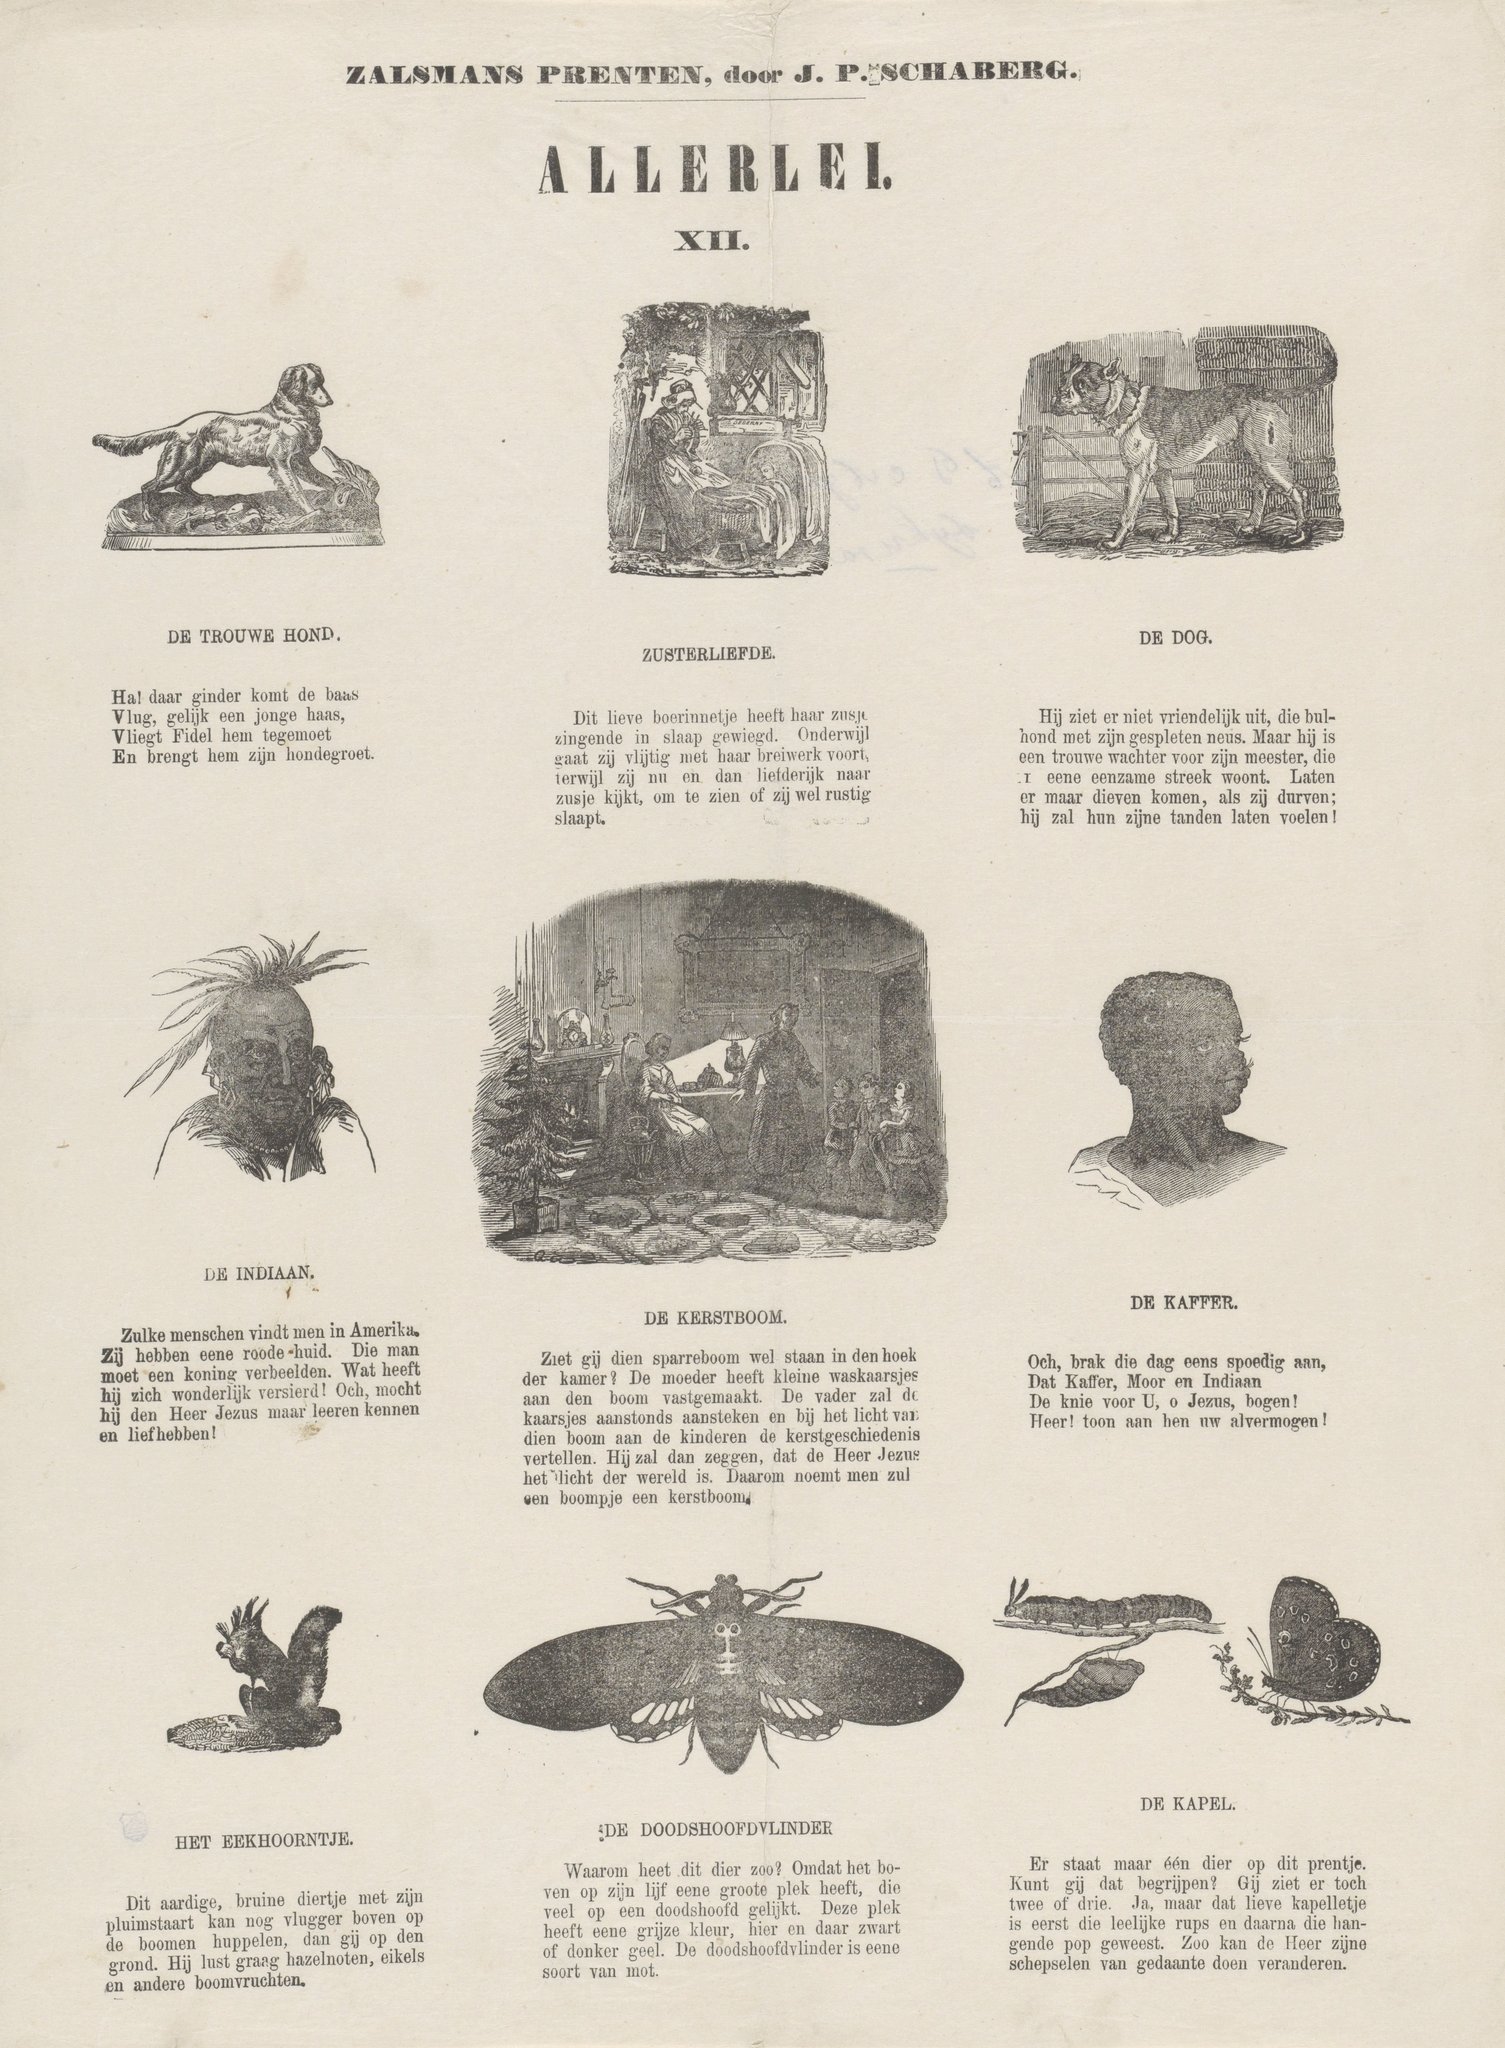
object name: print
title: Allerlei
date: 1869-1882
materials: paper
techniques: letterpress printing, engraving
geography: europe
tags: animals, american indian religions, human types, africans, indigenous peoples of north america, characters (human types), americans with african roots, african-americans, insects, dog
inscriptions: collector's mark: Lugt 2760, inscription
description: Blad met negen voorstellingen van mensen en dieren, zoals een eekhoorn, een oorspronkelijke Noord-Amerikaan en zusterliefde. Onder elke voorstelling een onderschrift. Genummerd midden boven: XII.